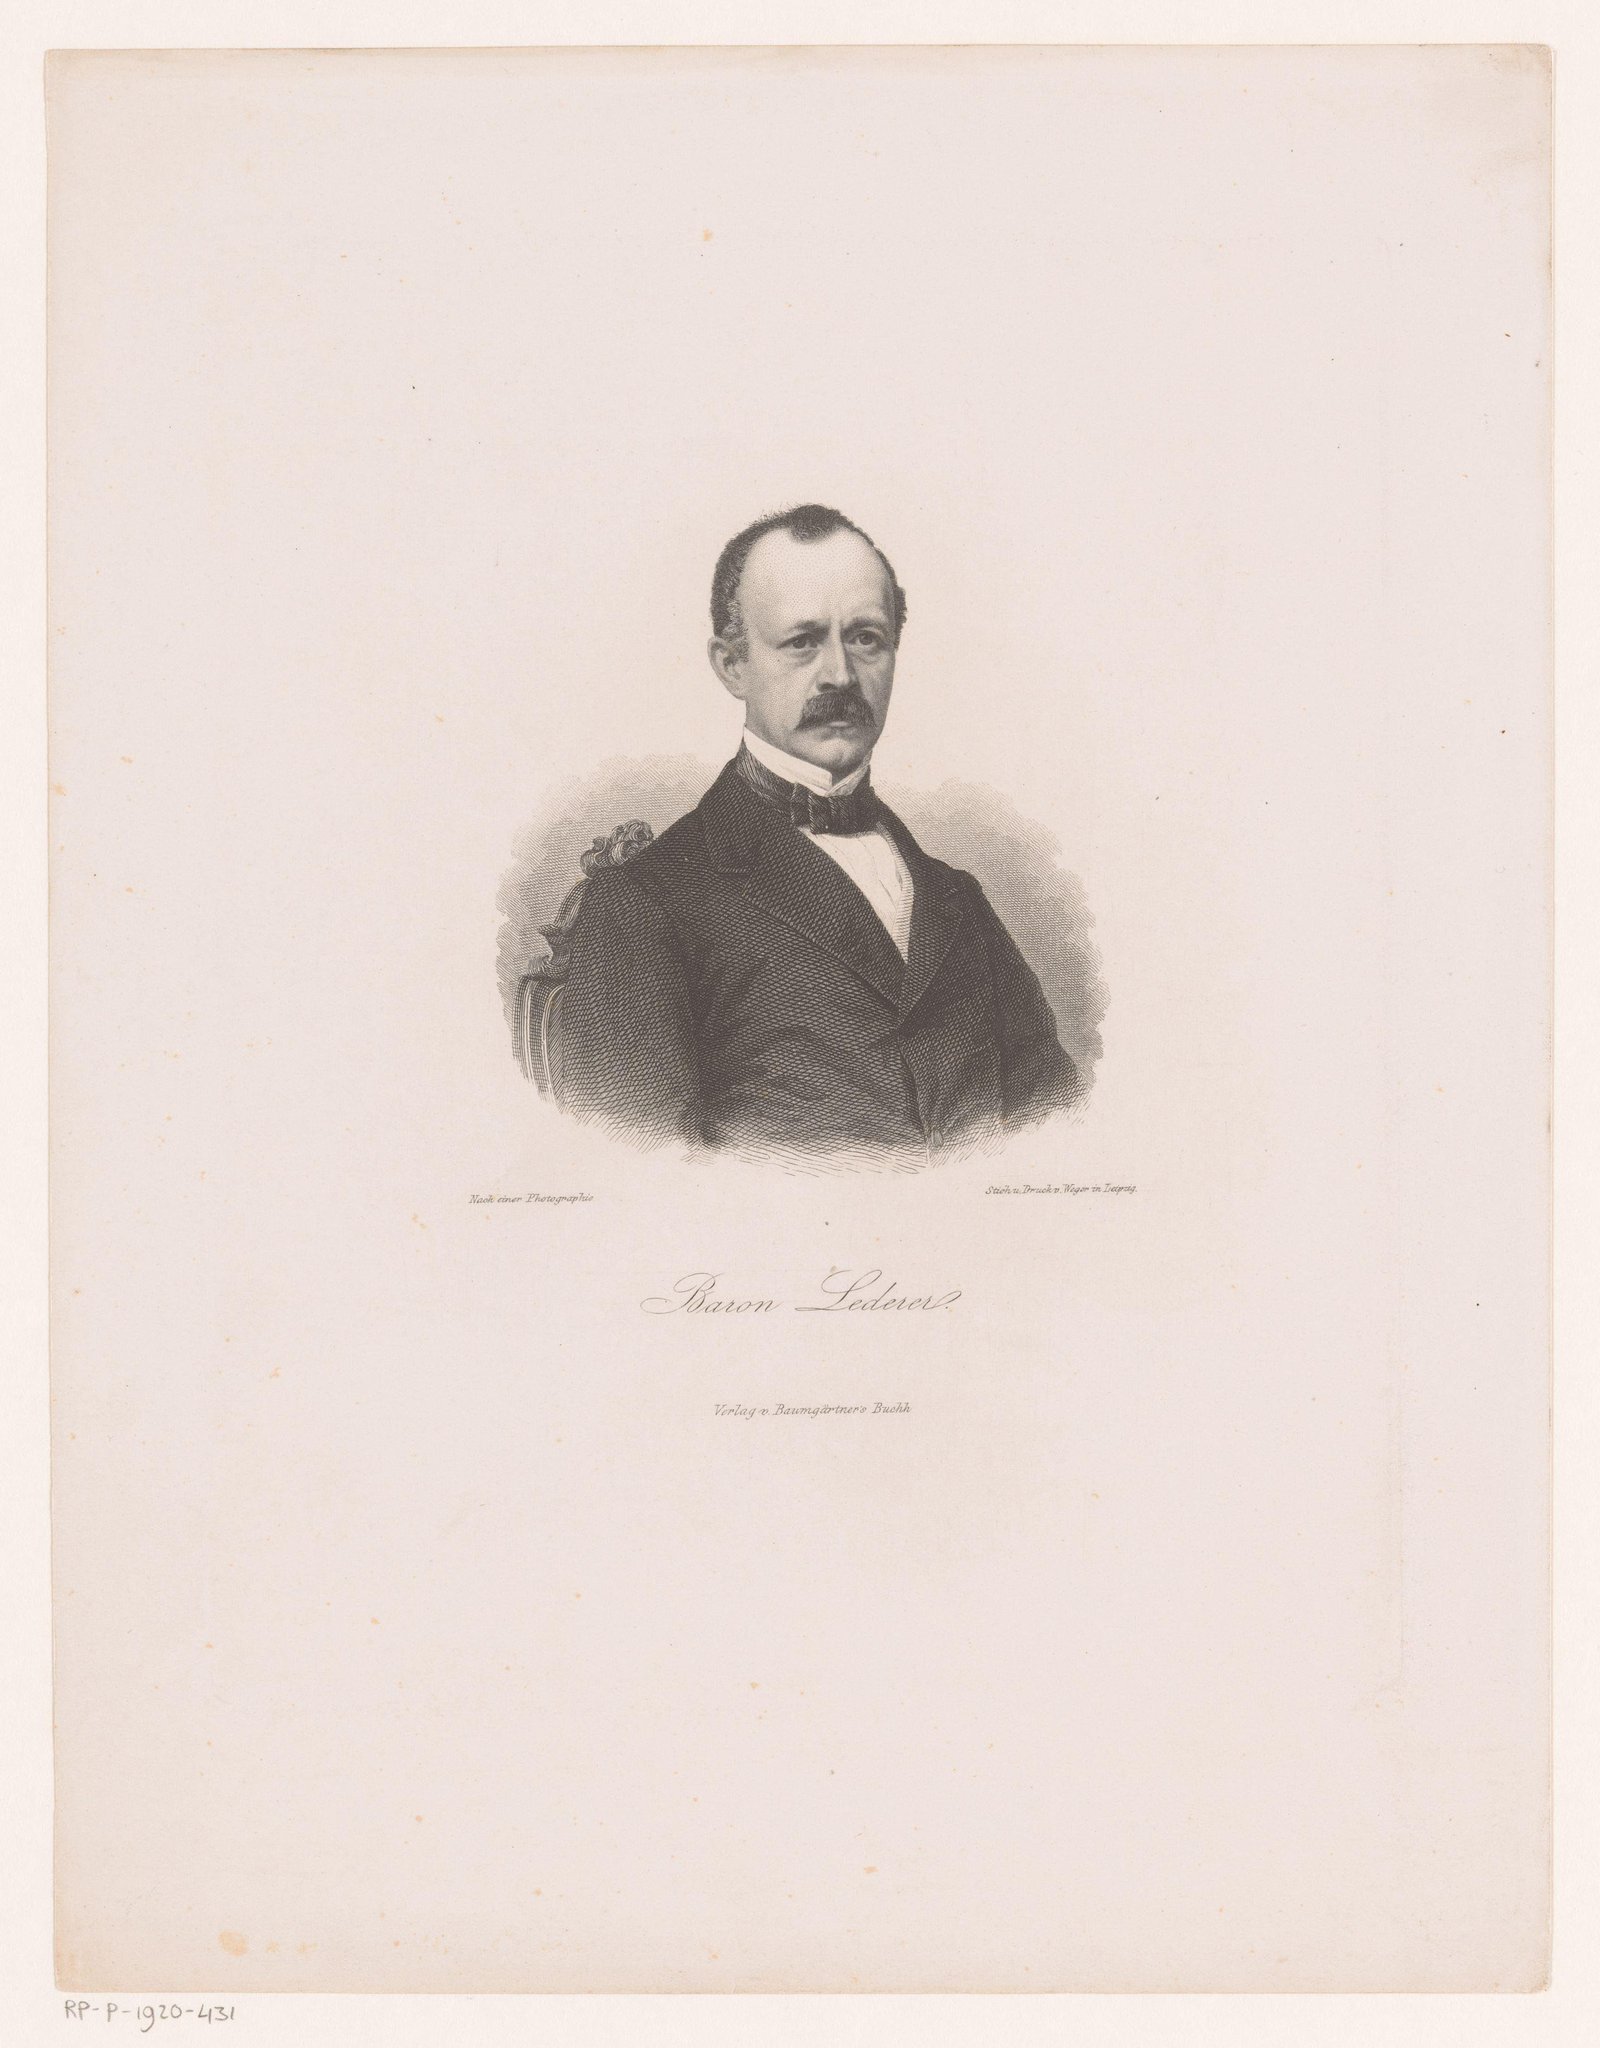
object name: print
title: Portret van Carl Ramon Soter von Lederer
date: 1860-1892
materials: paper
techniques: engraving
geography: leipzig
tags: italy, historical persons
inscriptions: collector's mark: Lugt 2228